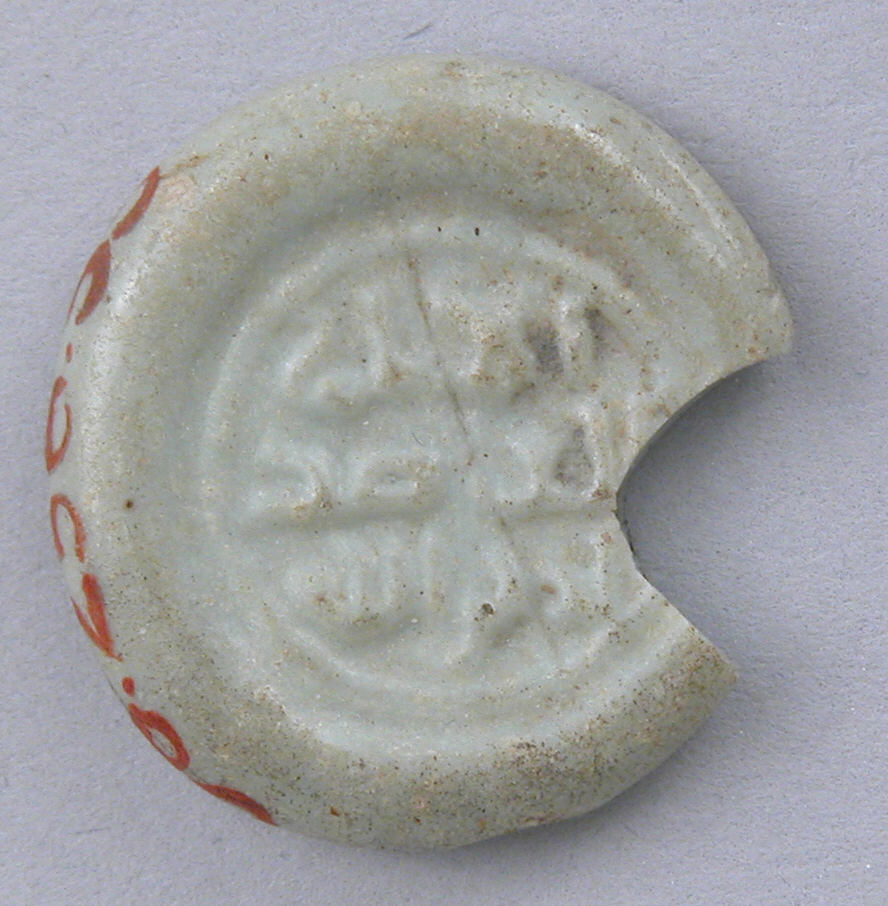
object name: coin weight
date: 1101-1200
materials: glass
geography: egypt